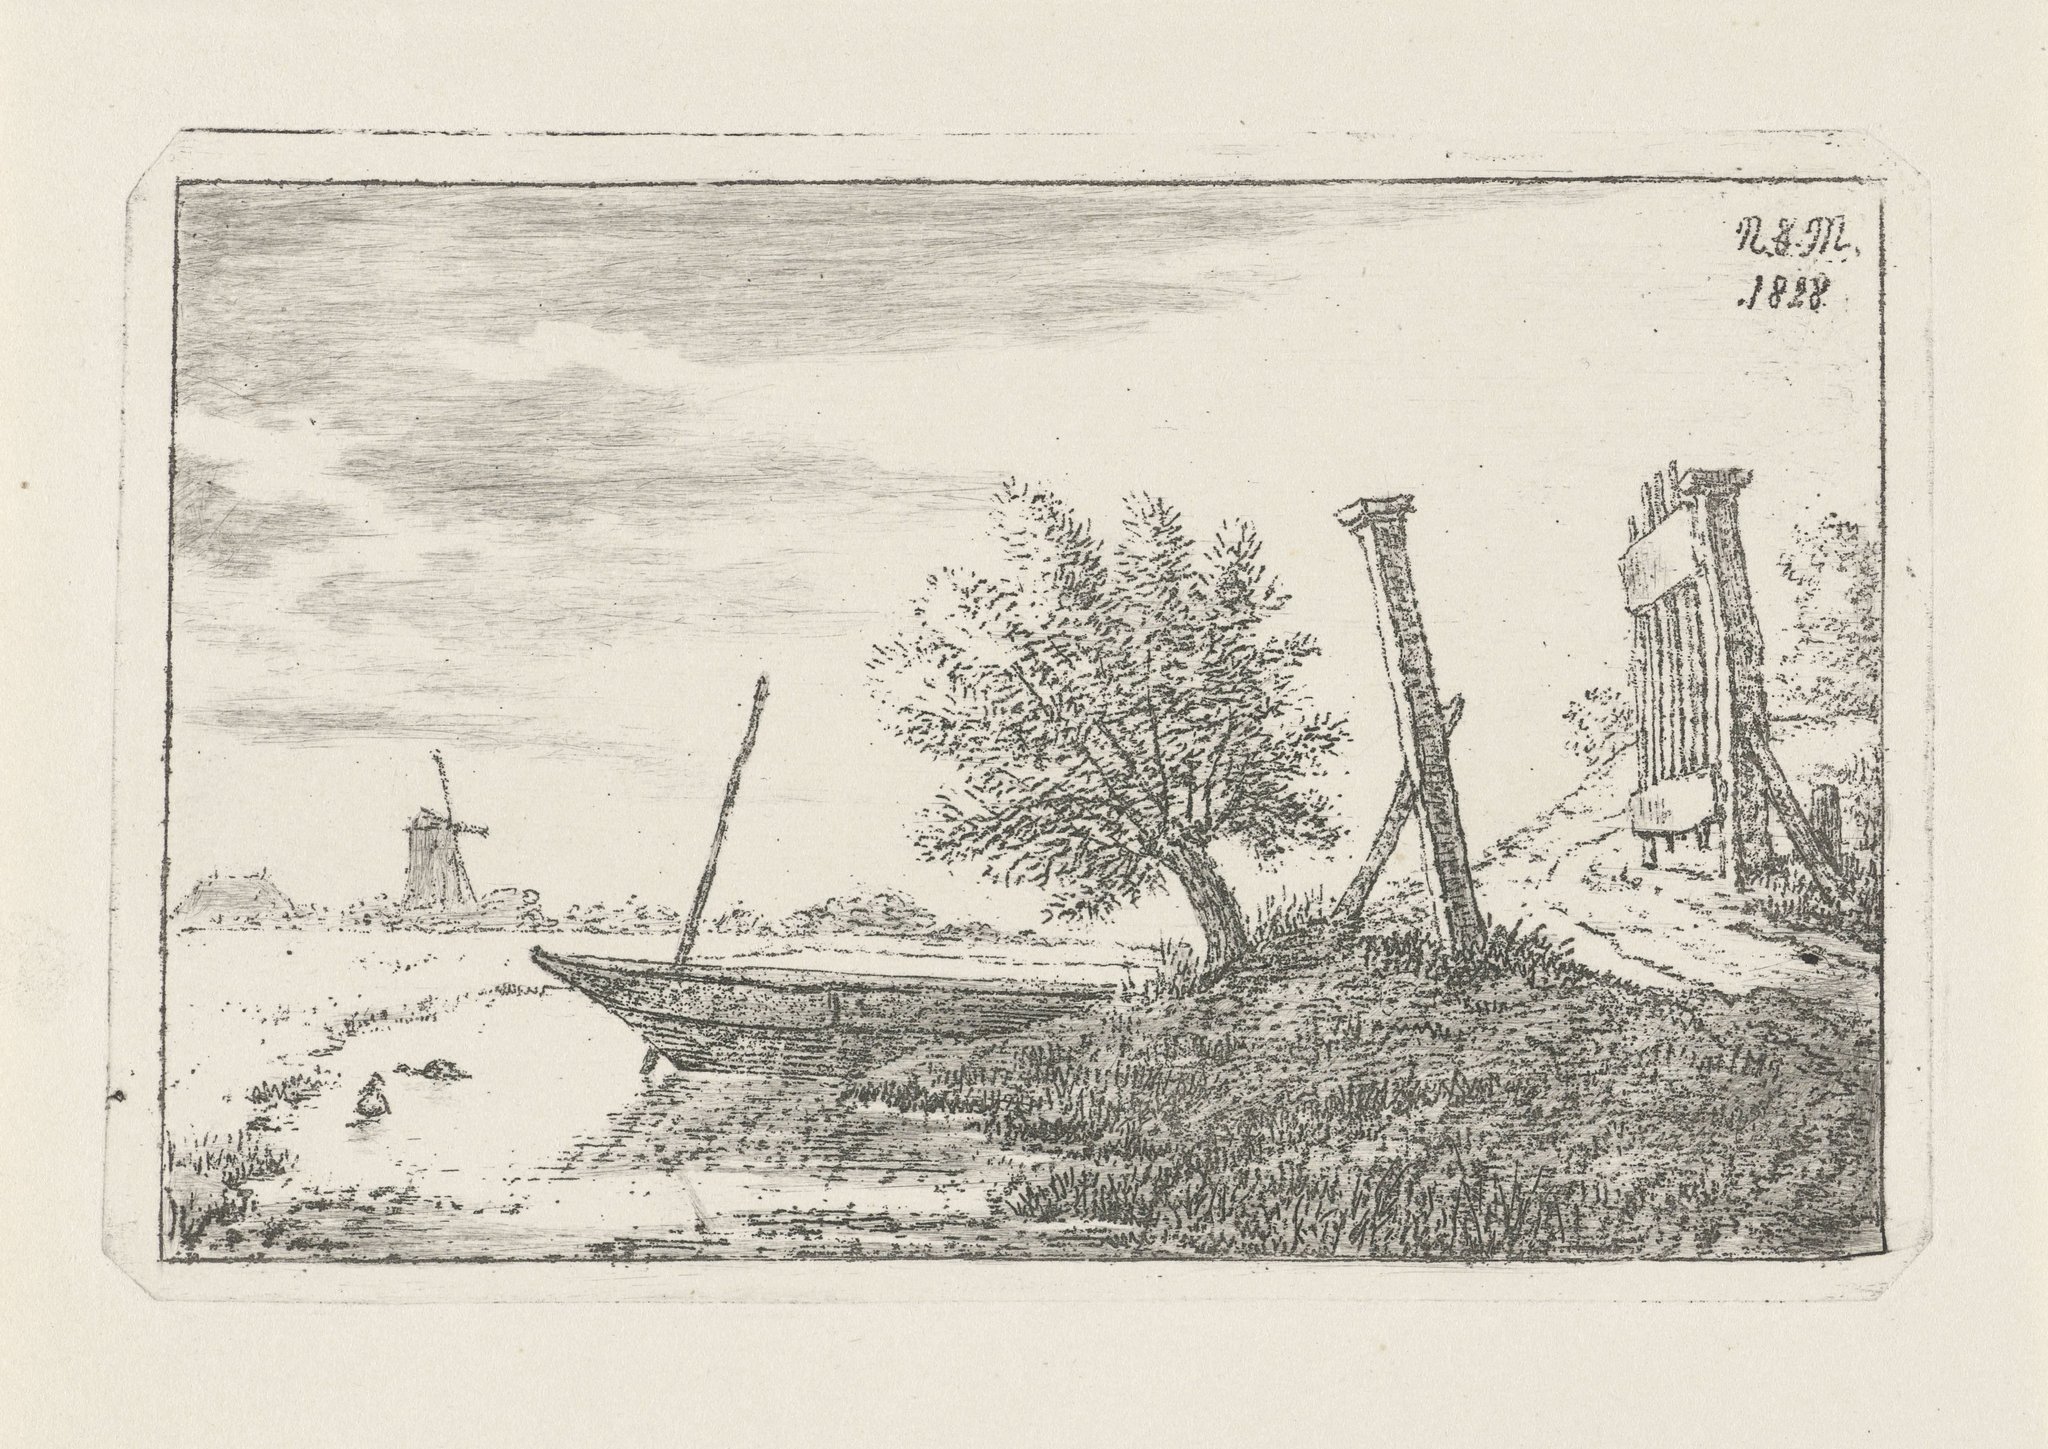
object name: print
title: Landschap met boot en openstaand hek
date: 1828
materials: paper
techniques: etching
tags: rowing-boat, canoe, etc., gate, entrance, windmill in landscape, brook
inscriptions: collector's mark: Lugt 2228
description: Een polderlandschap met rechts een openstaand hek. In de sloot een boot en aan de horizon een molen.